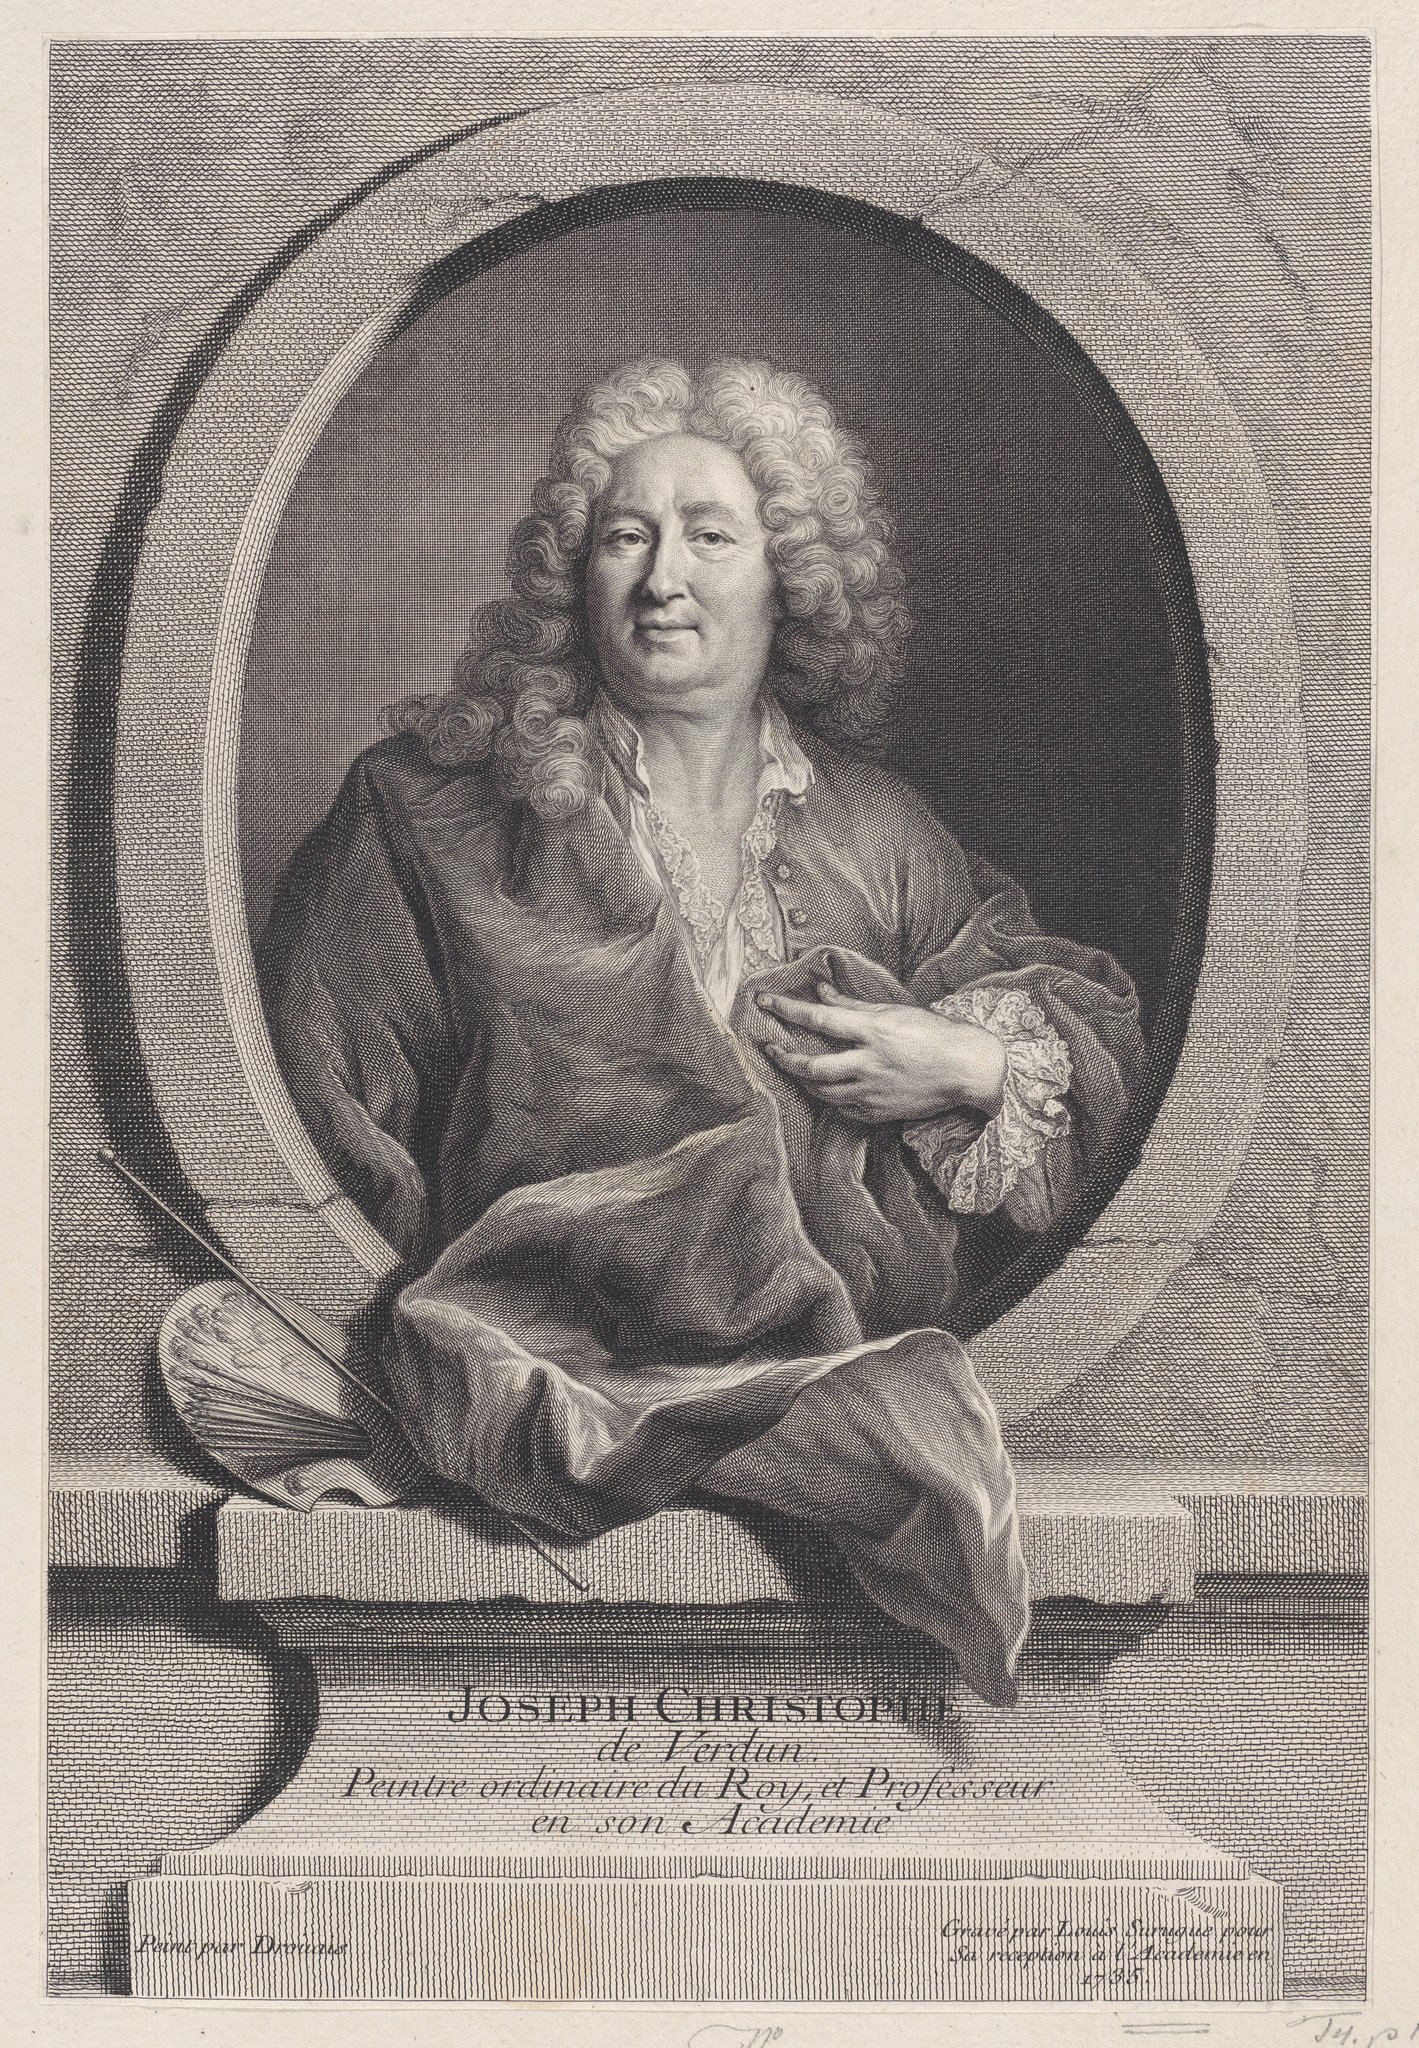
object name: print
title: Portrait of Joseph Christophe de Verdun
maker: louis surugue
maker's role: artist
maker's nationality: french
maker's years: 1686-1762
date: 1735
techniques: engraving, etching